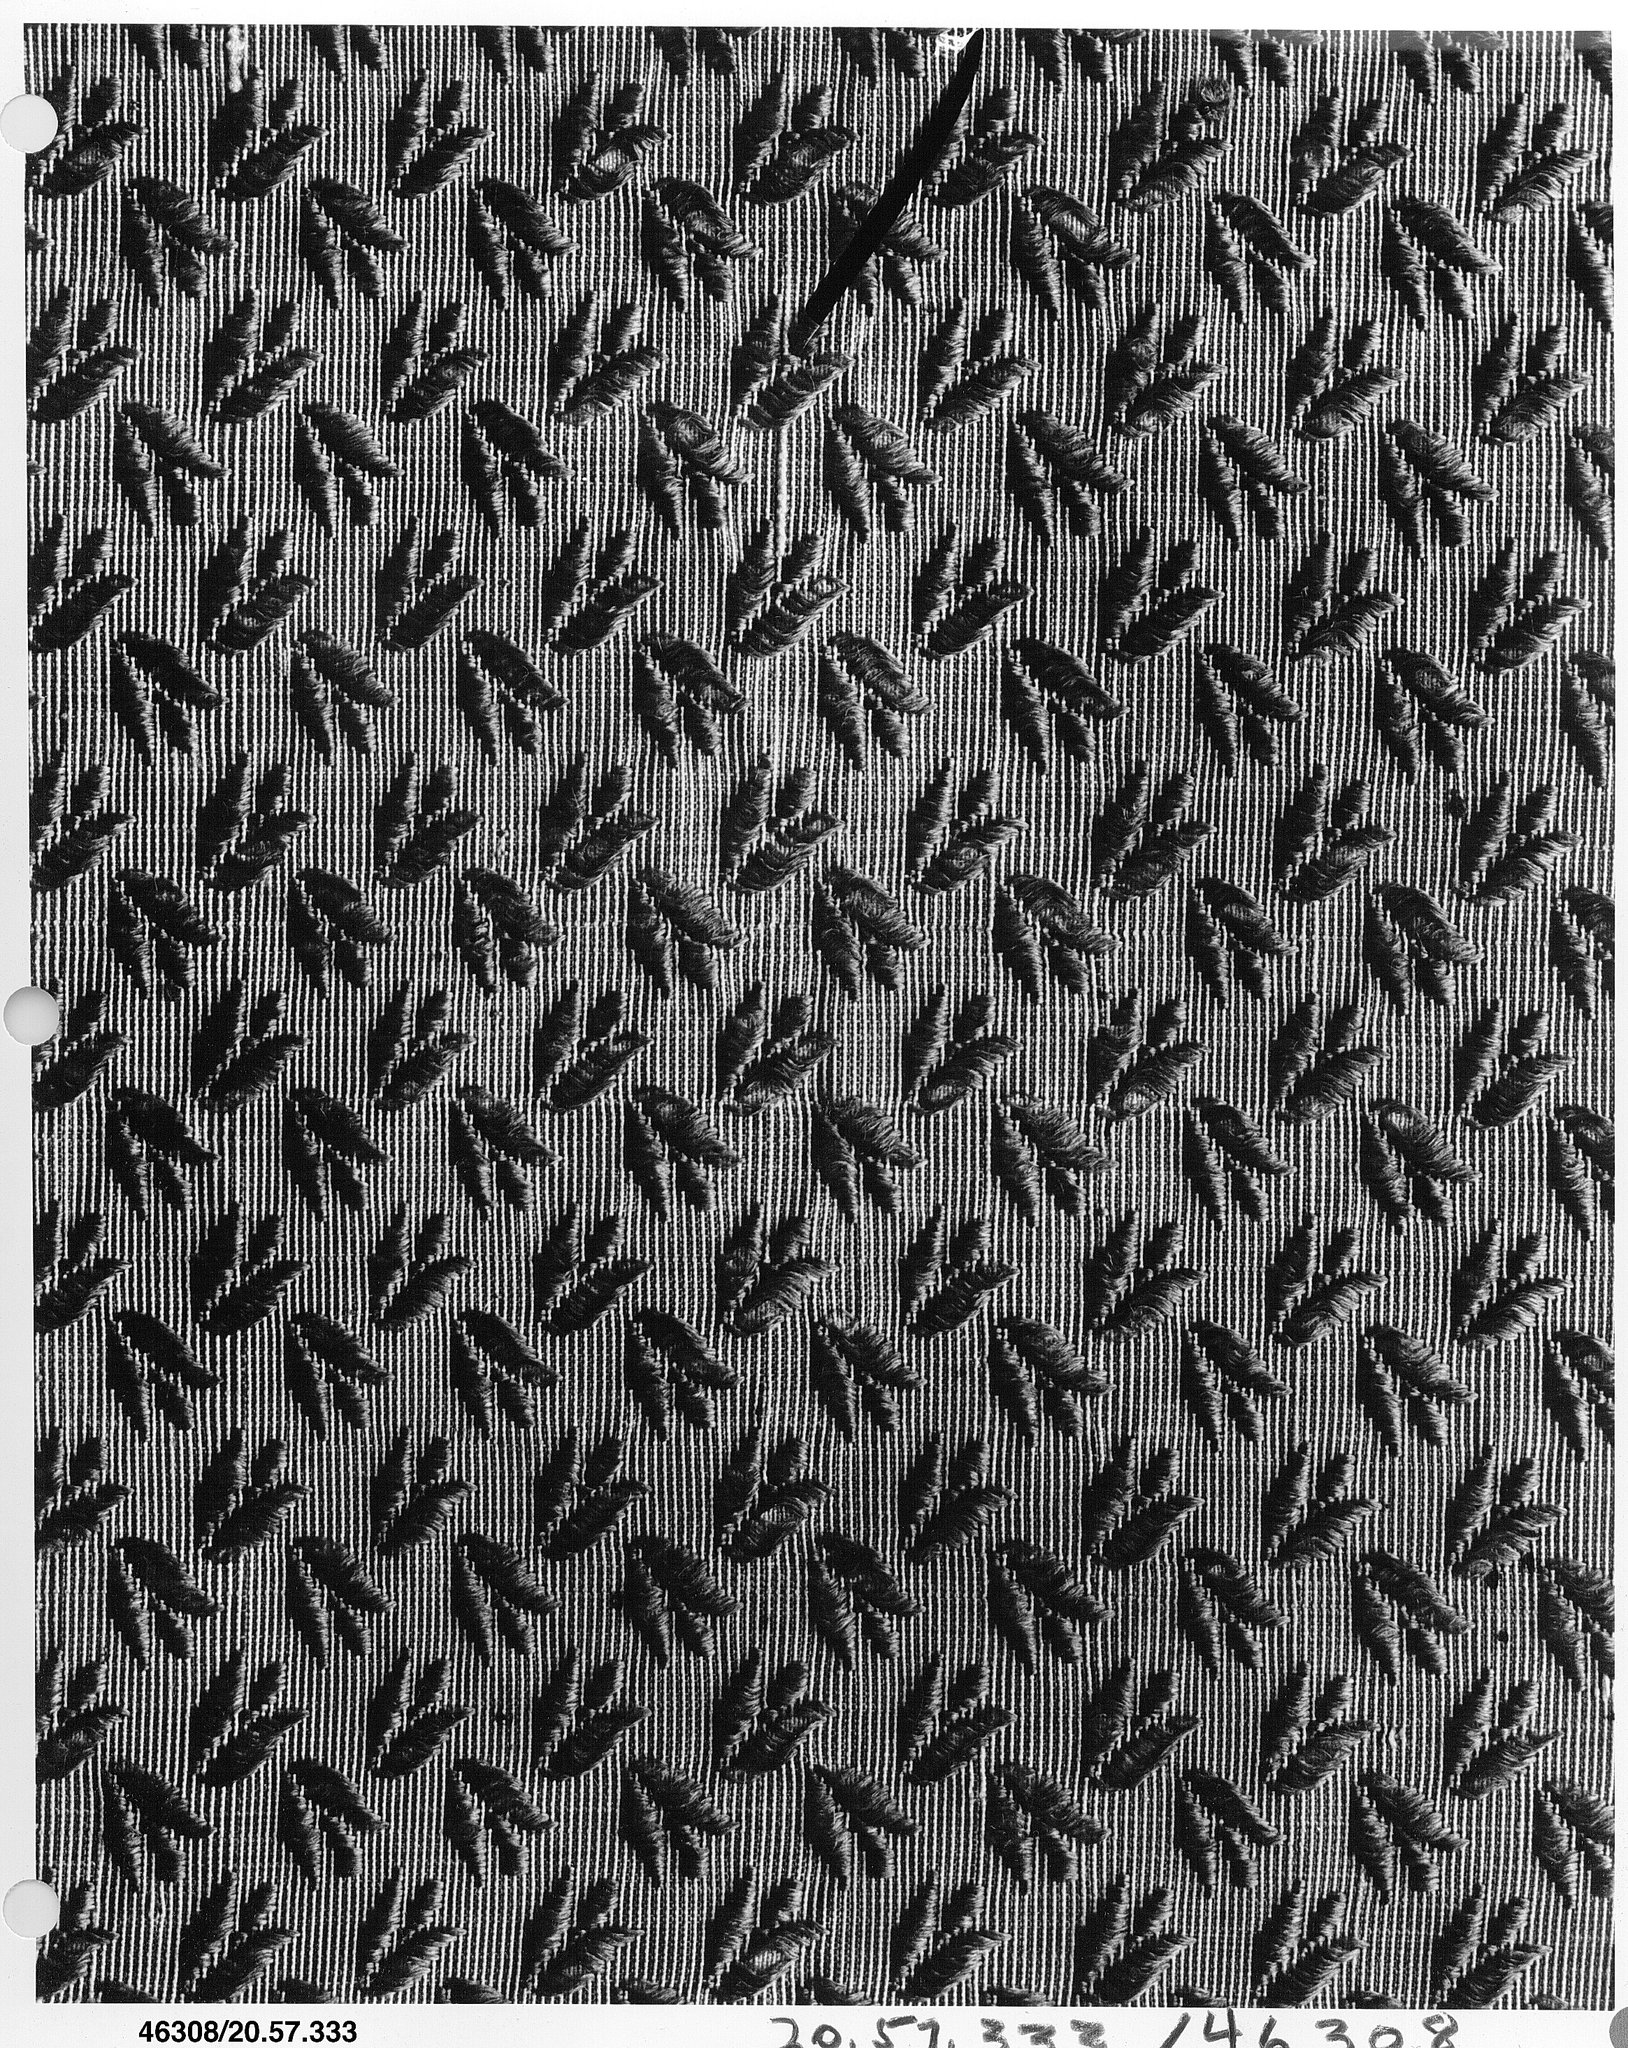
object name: piece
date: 1701-1800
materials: silk